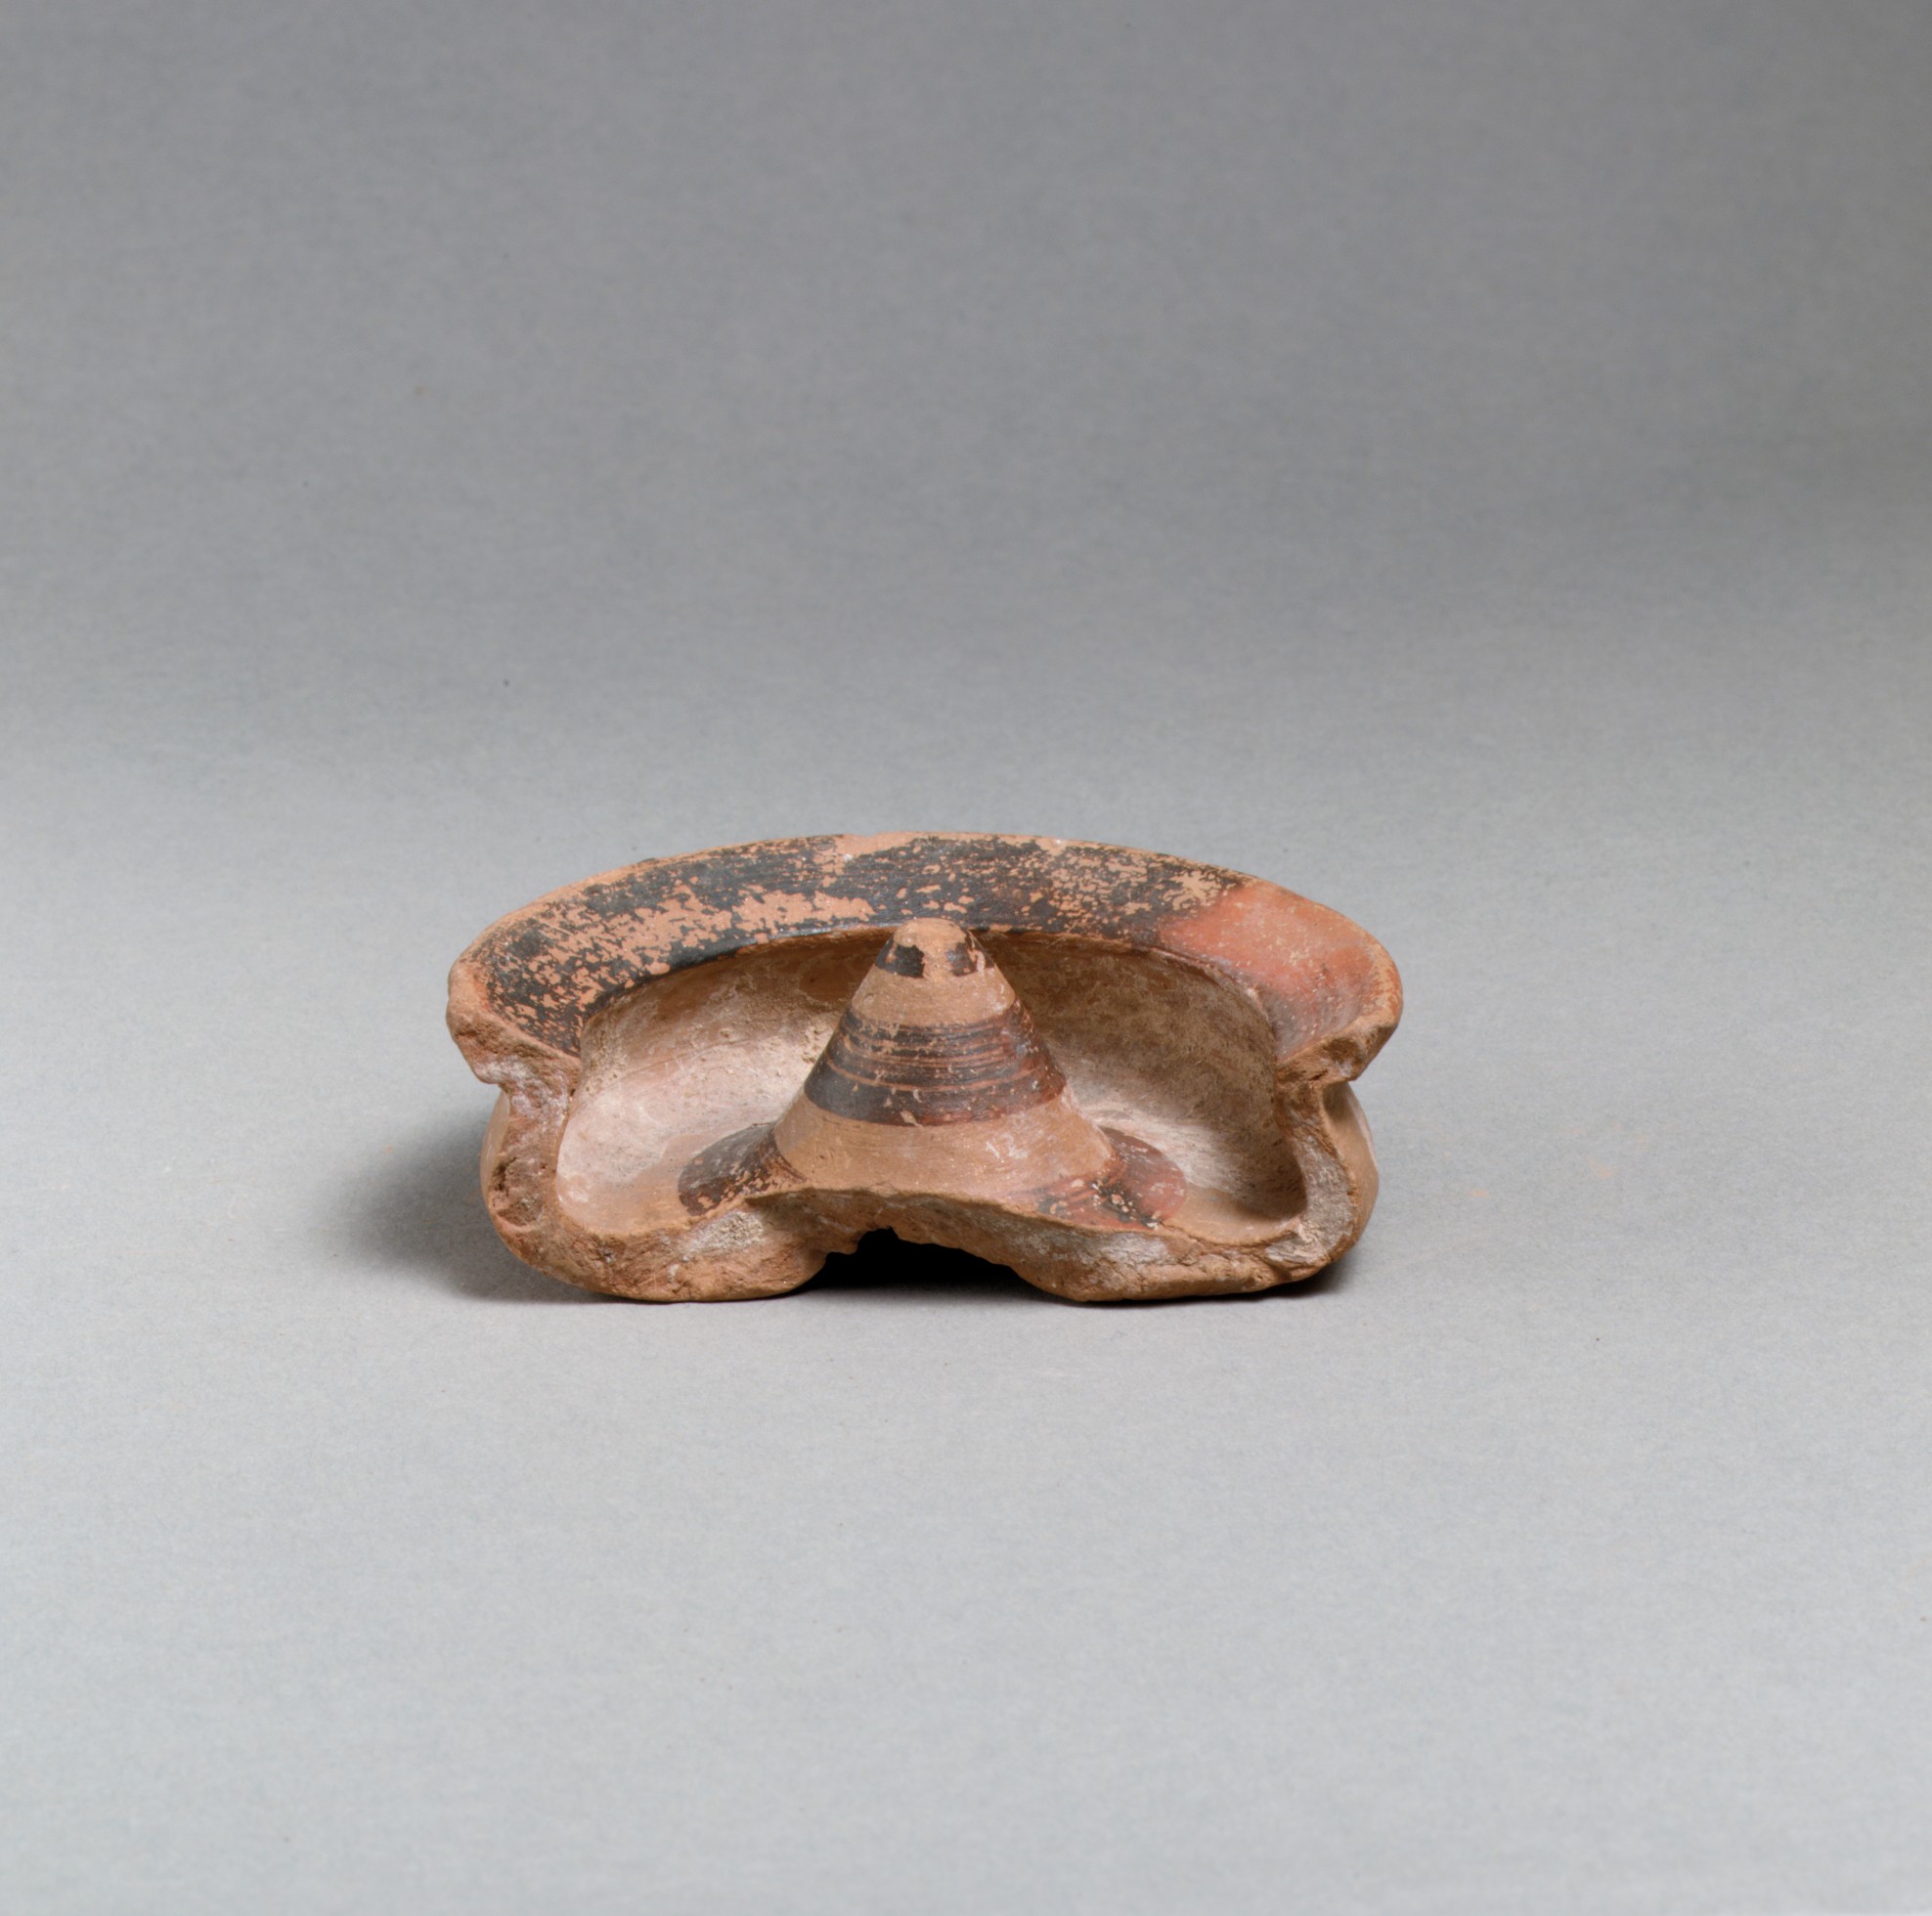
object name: lamp fragment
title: Terracotta lamp fragment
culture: greek or lydian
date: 900-30 BCE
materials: terracotta